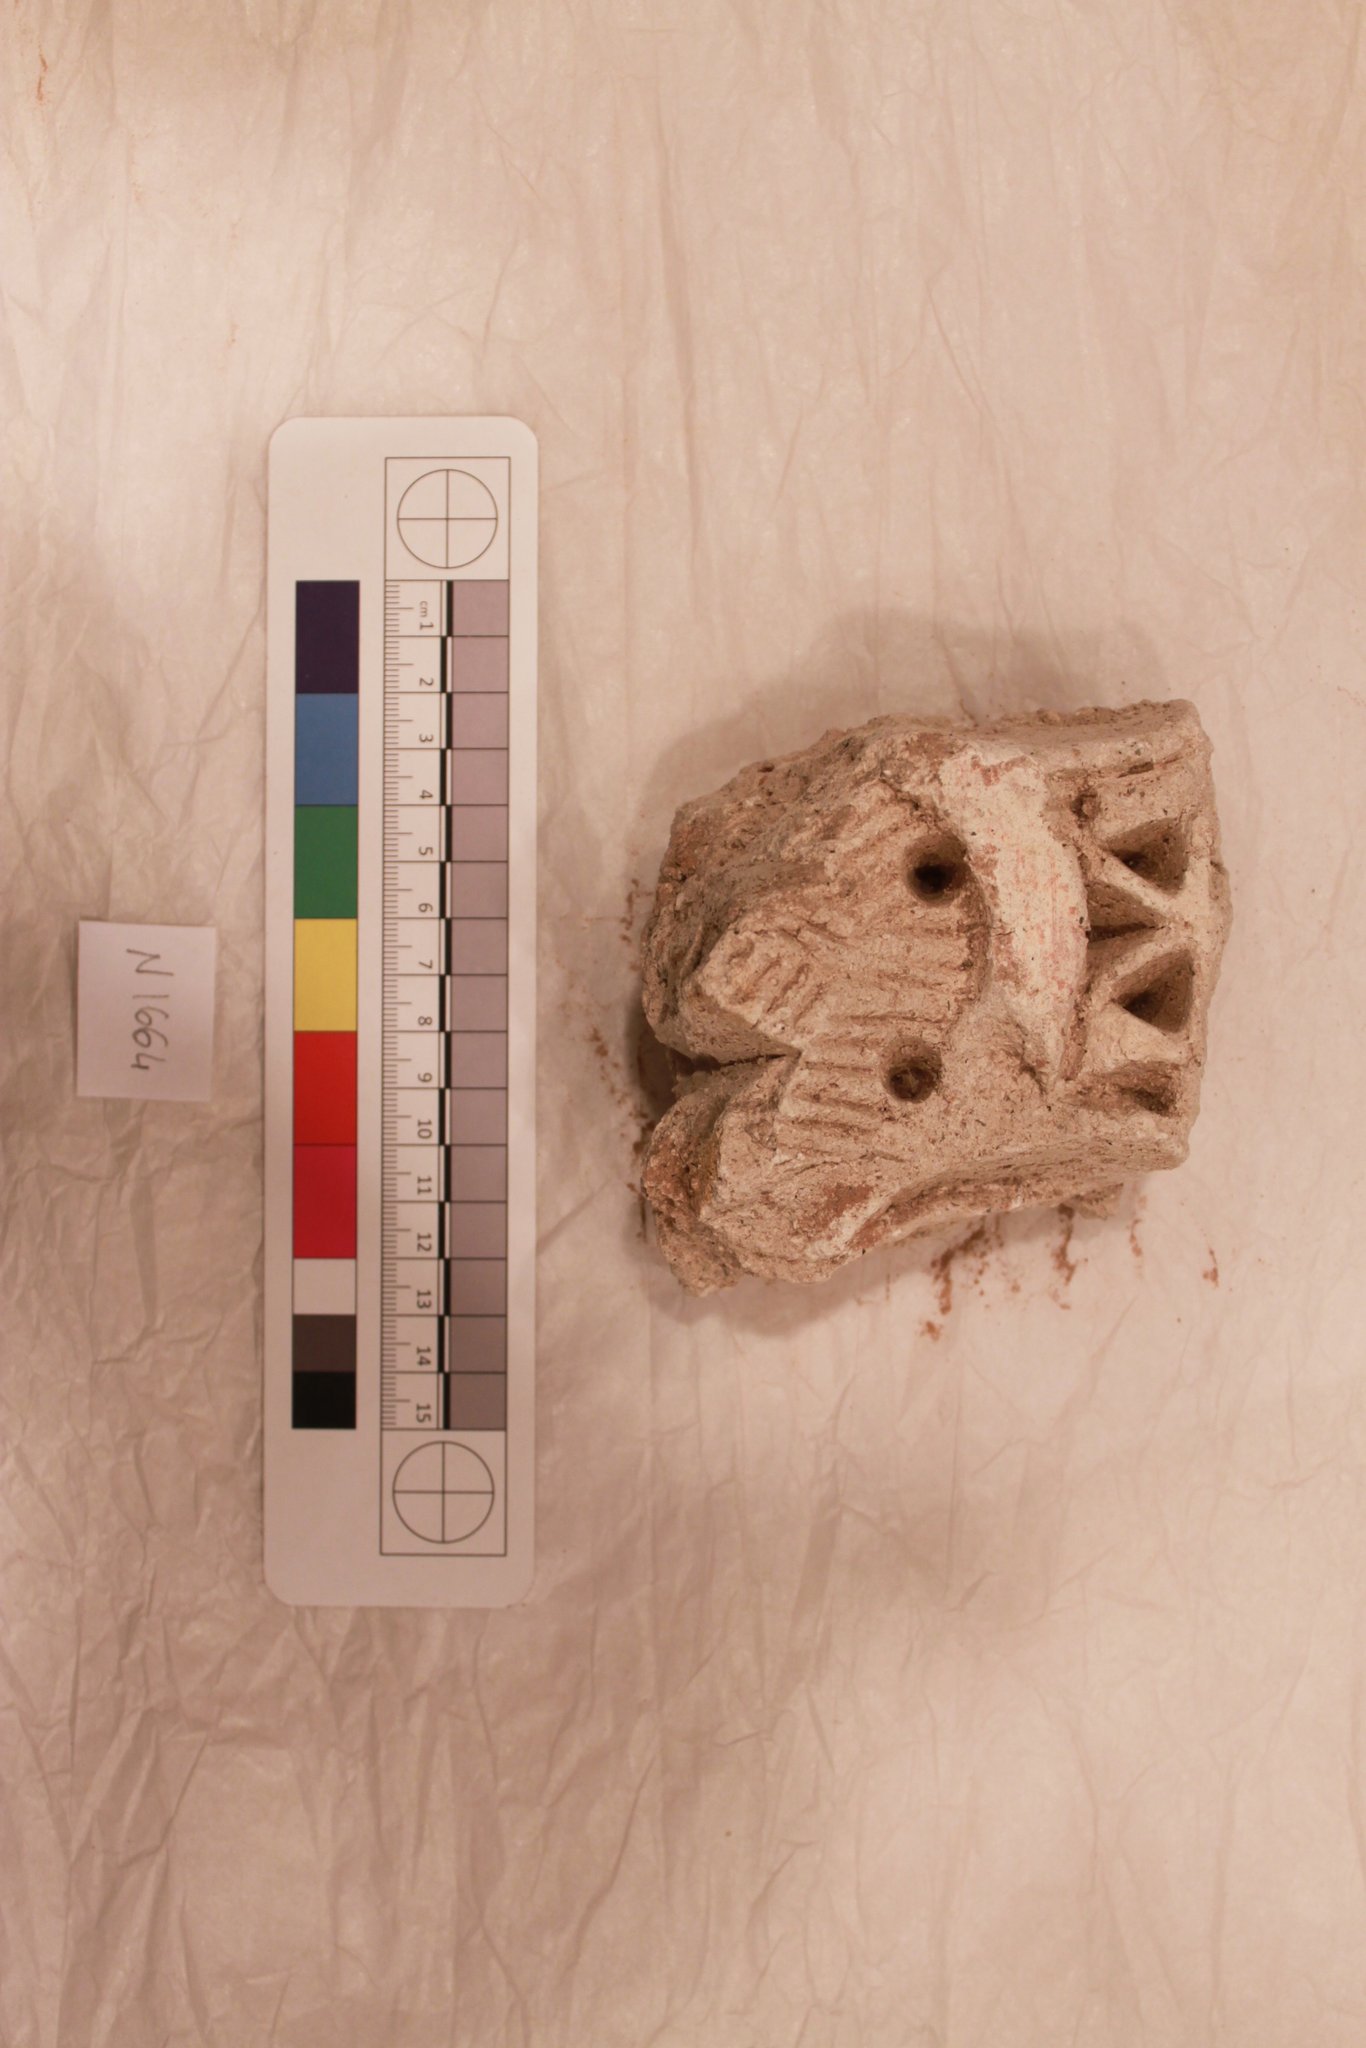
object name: fragment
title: Stucco Fragment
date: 701-1200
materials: plaster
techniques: carving, painting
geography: iran